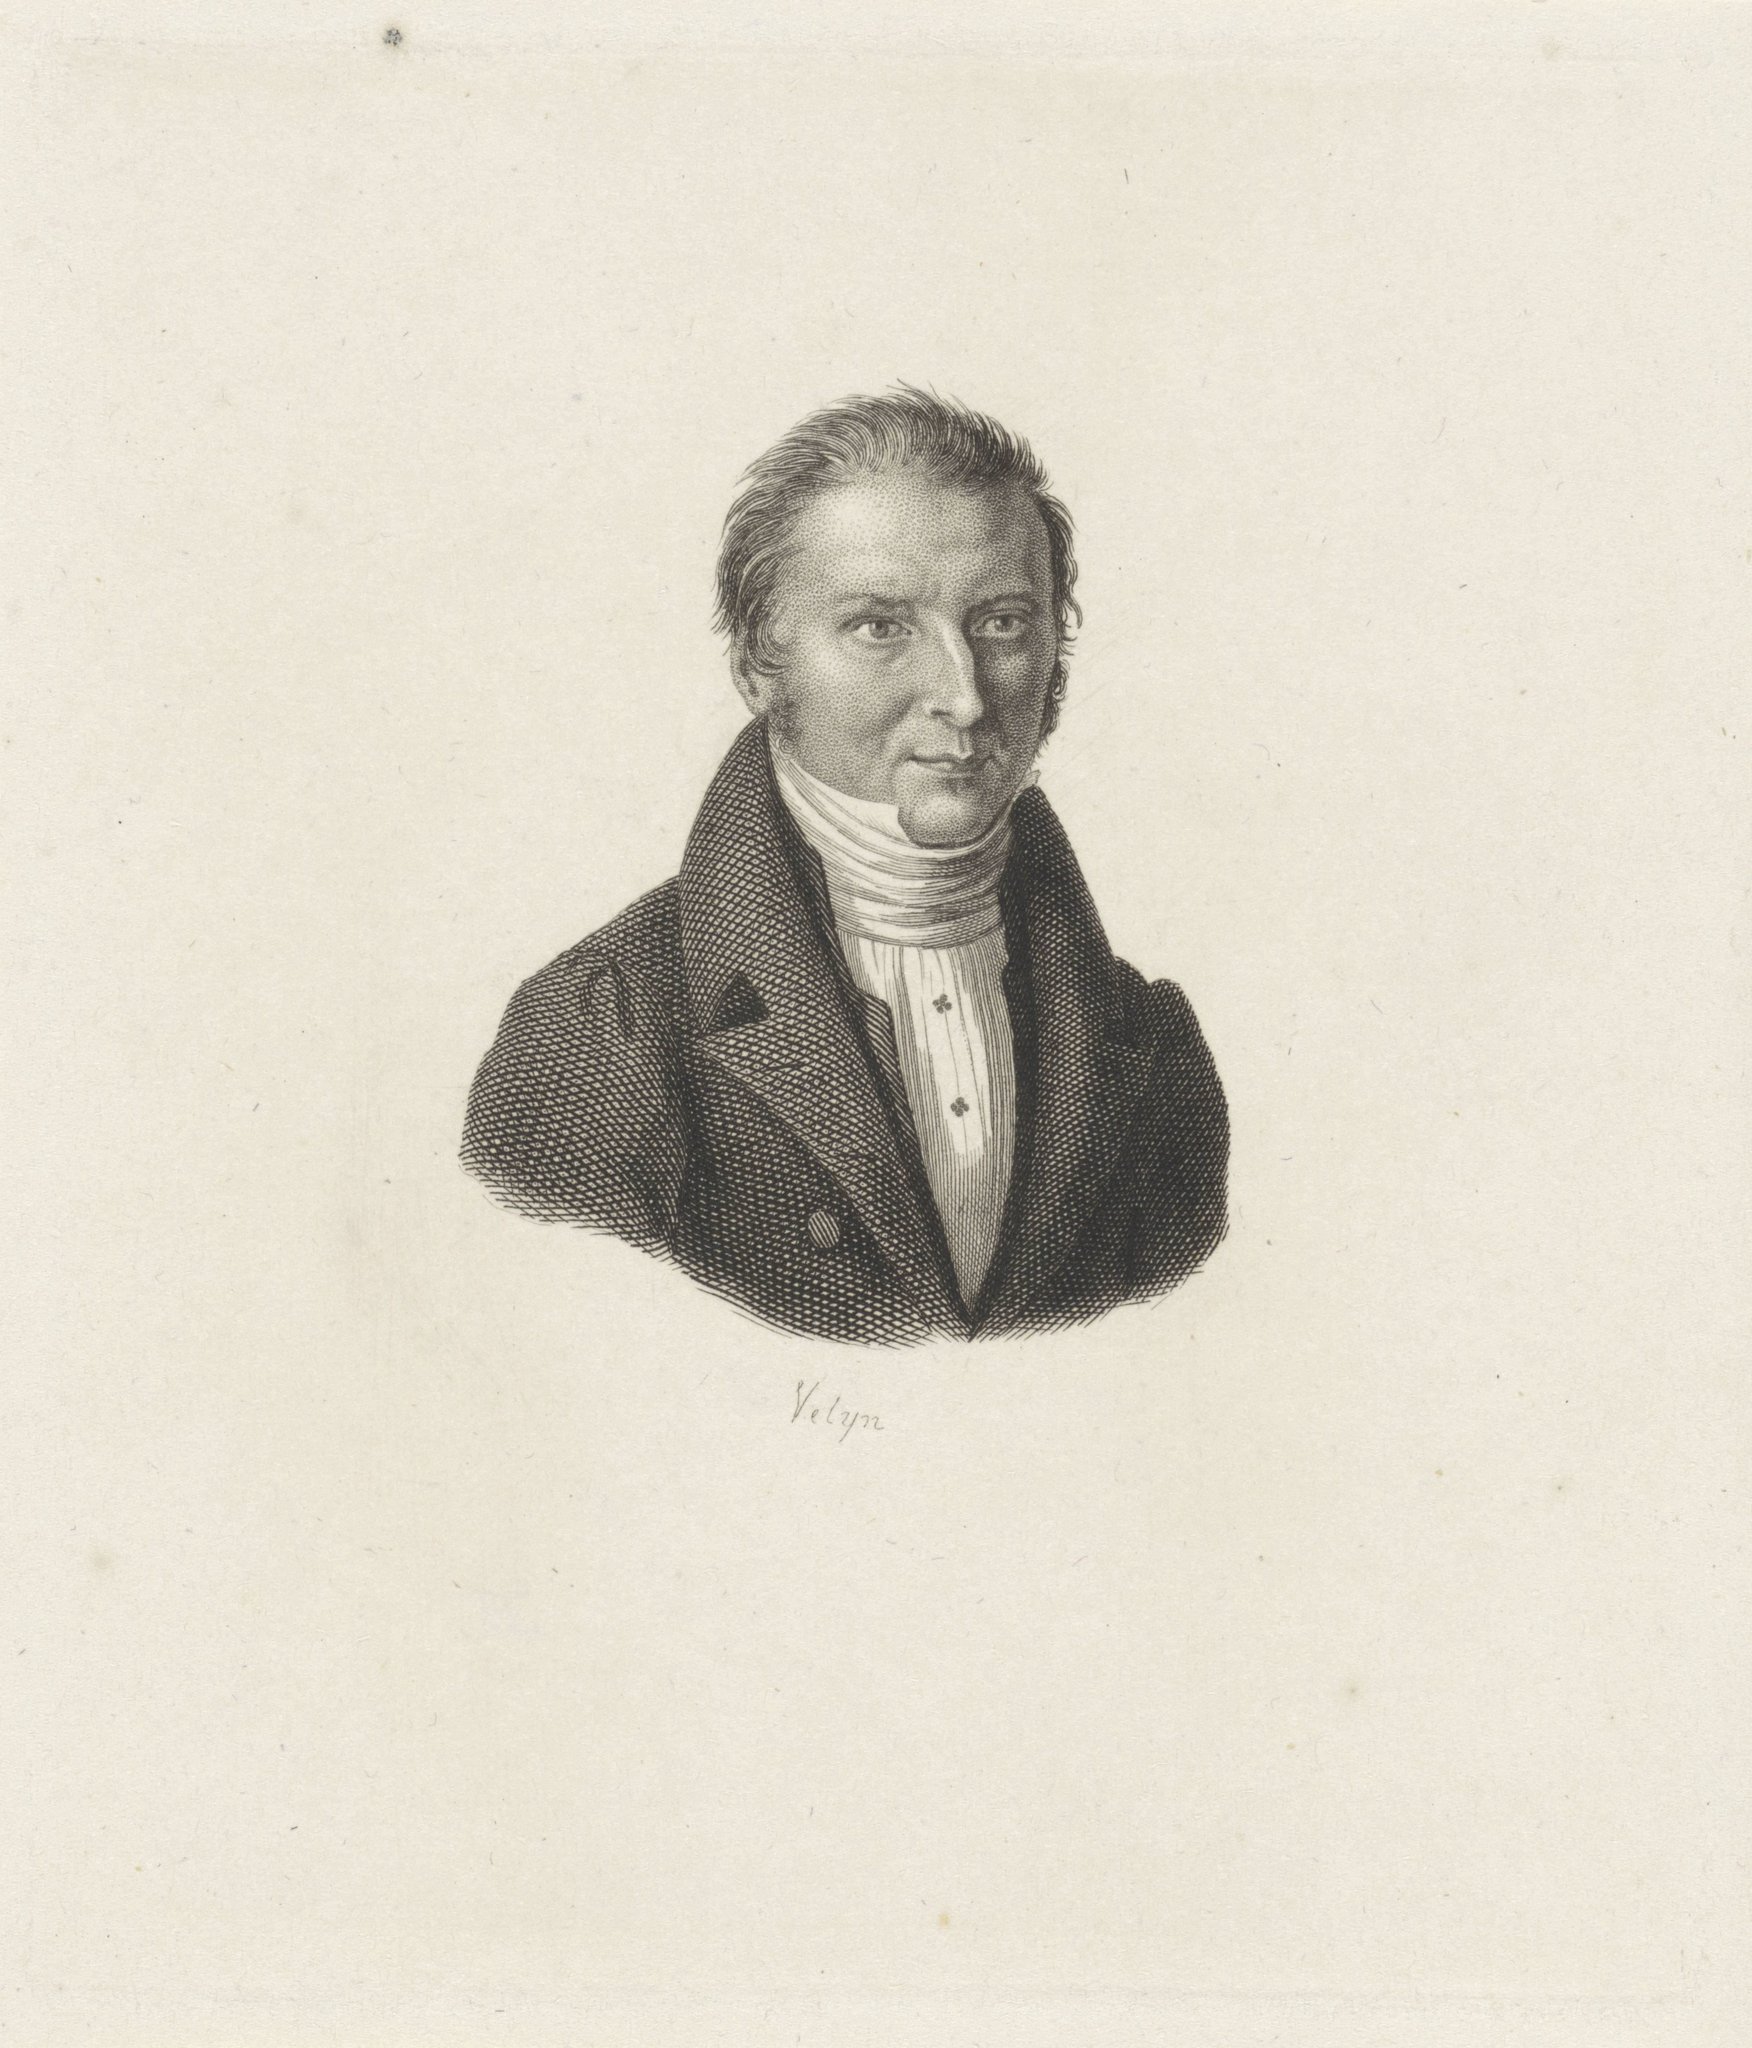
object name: print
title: Portret van Alexander François Sifflé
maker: philippus velijn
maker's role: print maker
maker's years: 1787-1836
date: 1836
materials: paper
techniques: engraving, etching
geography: netherlands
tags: middelburg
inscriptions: collector's mark: Lugt 2228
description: Latere staat prent volgens Van Someren ook gebruikt in: Nederlandsche Muzen-Almanak. J. Immerzeel, 1836.